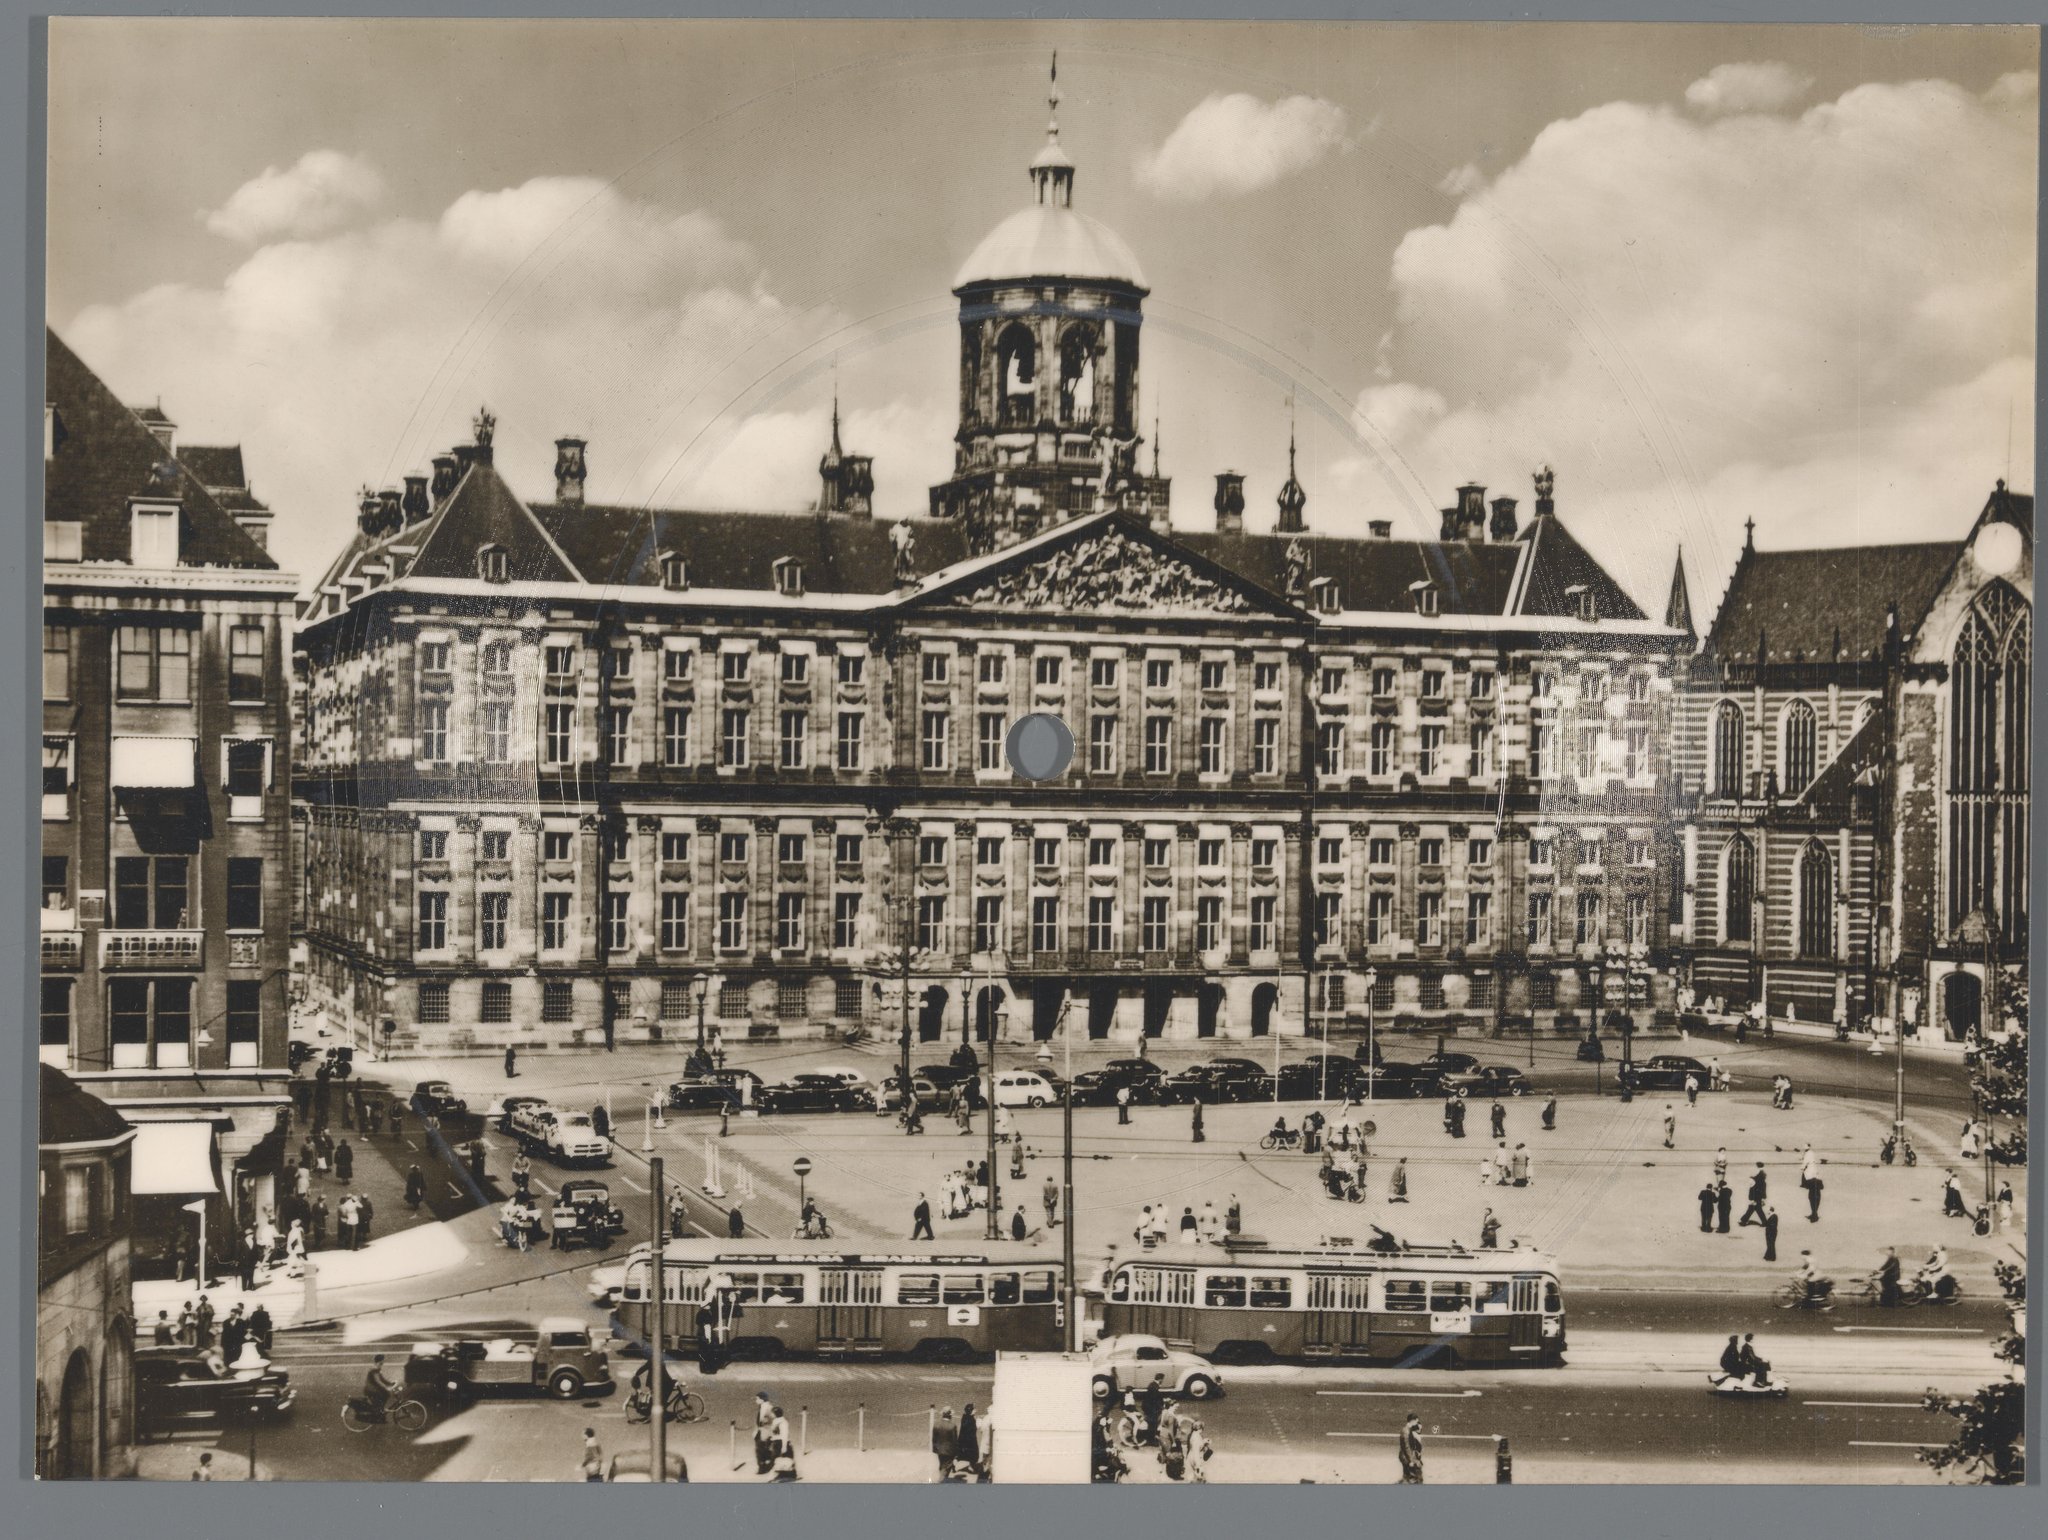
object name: ansichtkaart, prentbriefkaart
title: Fonokaart: prentbriefkaart van het Koninklijk Paleis op de Dam, met groeven voor een grammofoonplaat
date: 1950-1970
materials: paper, cardboard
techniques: gelatin silver print, letterpress printing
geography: gröbenzell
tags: square, place, circus, etc., gramophone record, disc, compact disc, palace, royal palace of amsterdam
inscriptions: inscription: ‘Gramo-kaarten/ Amsterdam-Koninklijk Paleis/Dam/ "Glockenwalzer"/ Fabrikation F. Lindner, Gröbenzell bei München, Telefon Olching 9793/ (...)/ Ansichtskaart met gramofoonplaat op 45 toeren (...)’